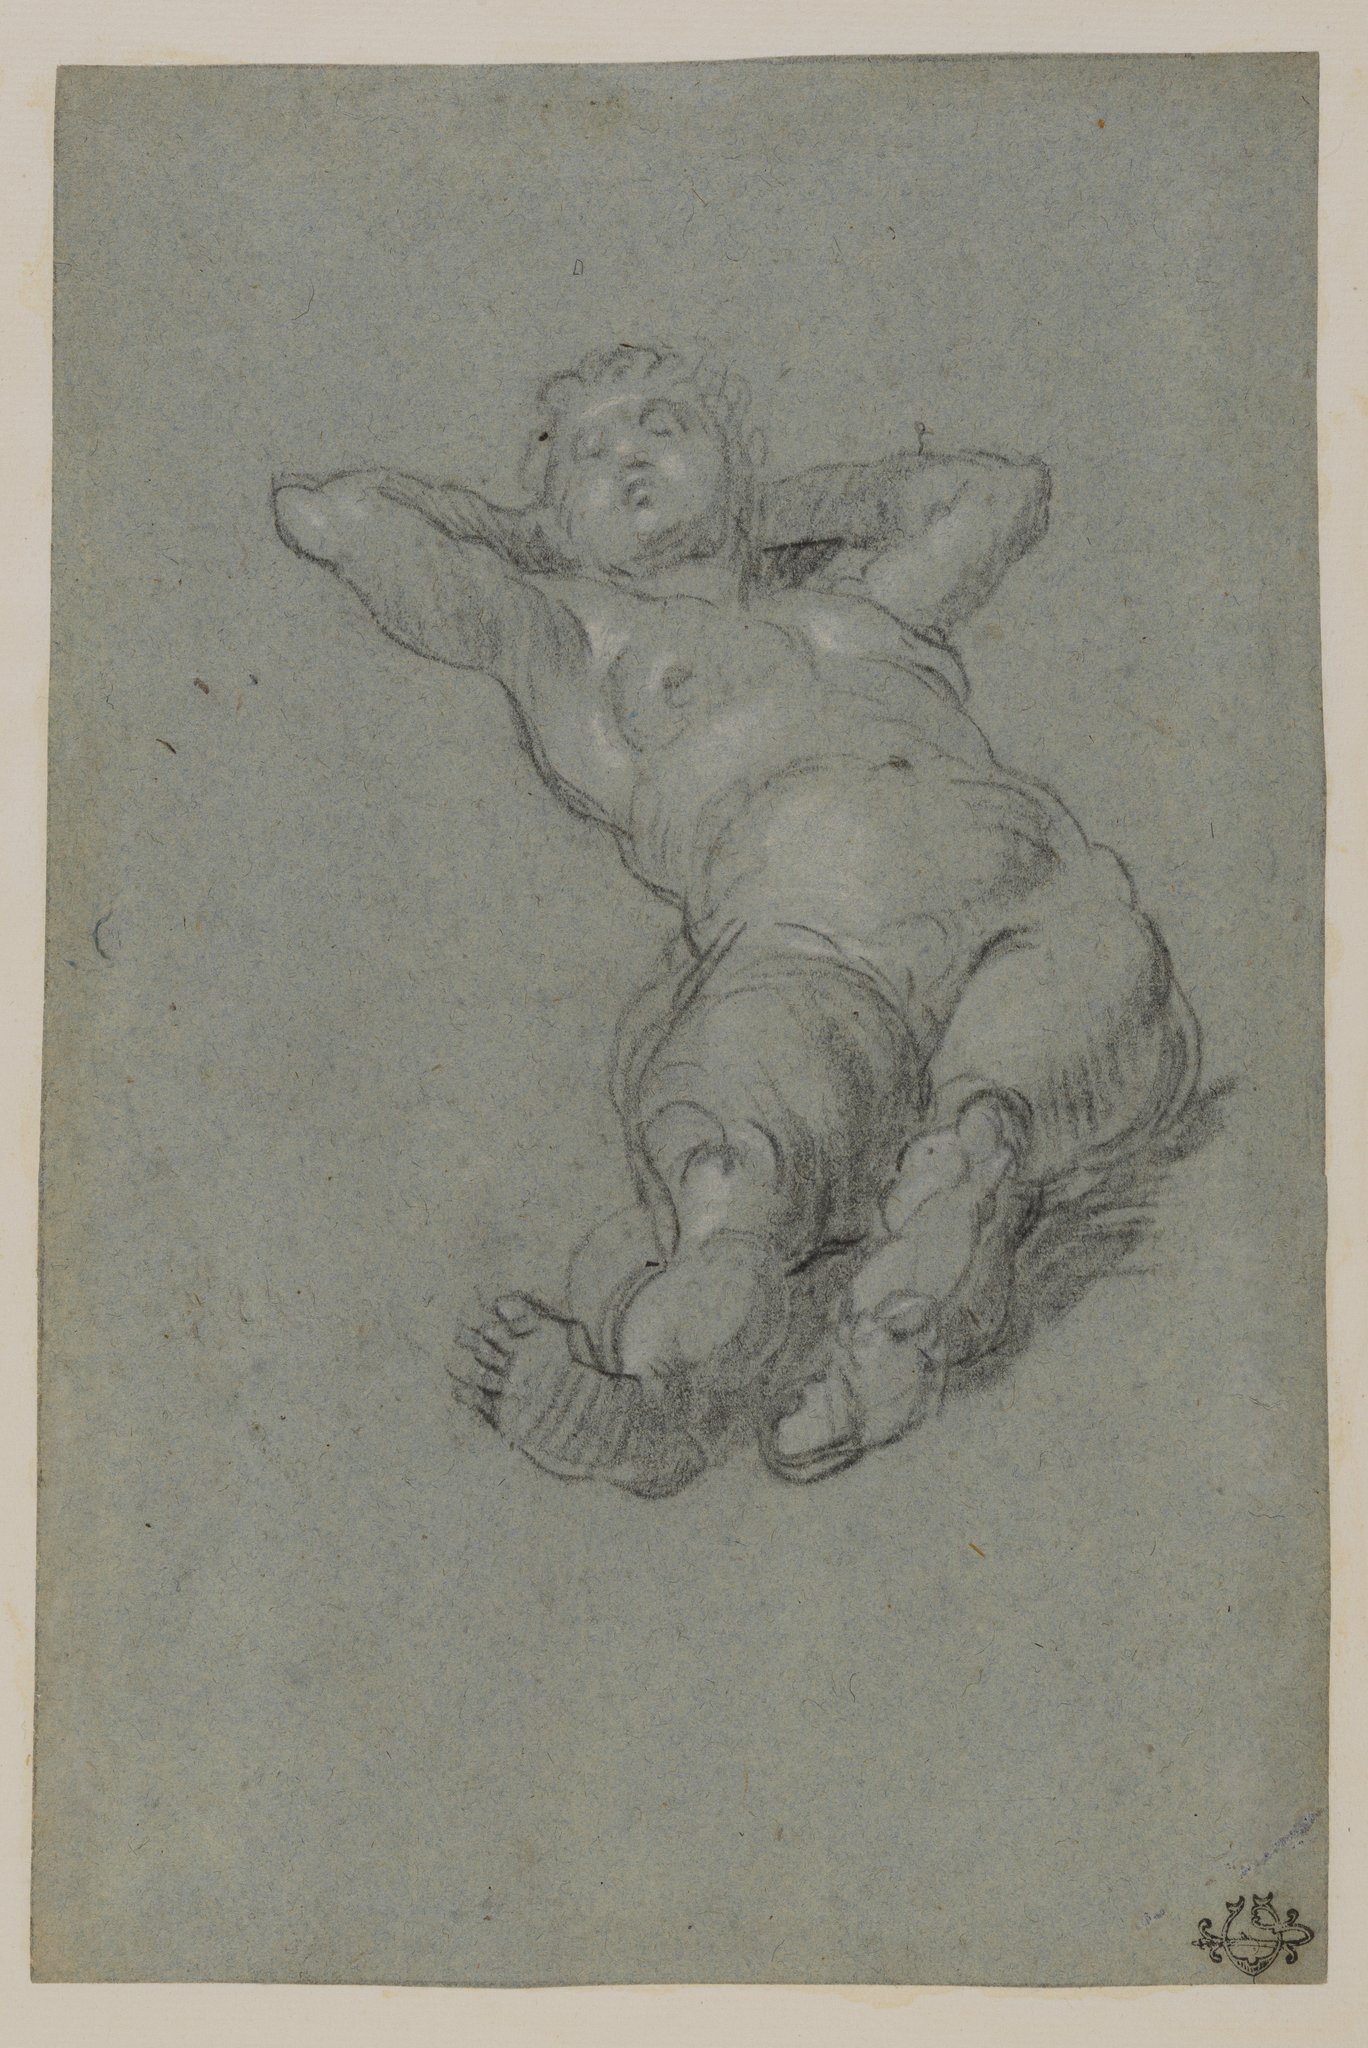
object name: drawing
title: Reclining Female Nude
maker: domenico tintoretto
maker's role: artist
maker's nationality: italian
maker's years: 1560-1635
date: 1601-1633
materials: chalk, paper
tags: female nudes